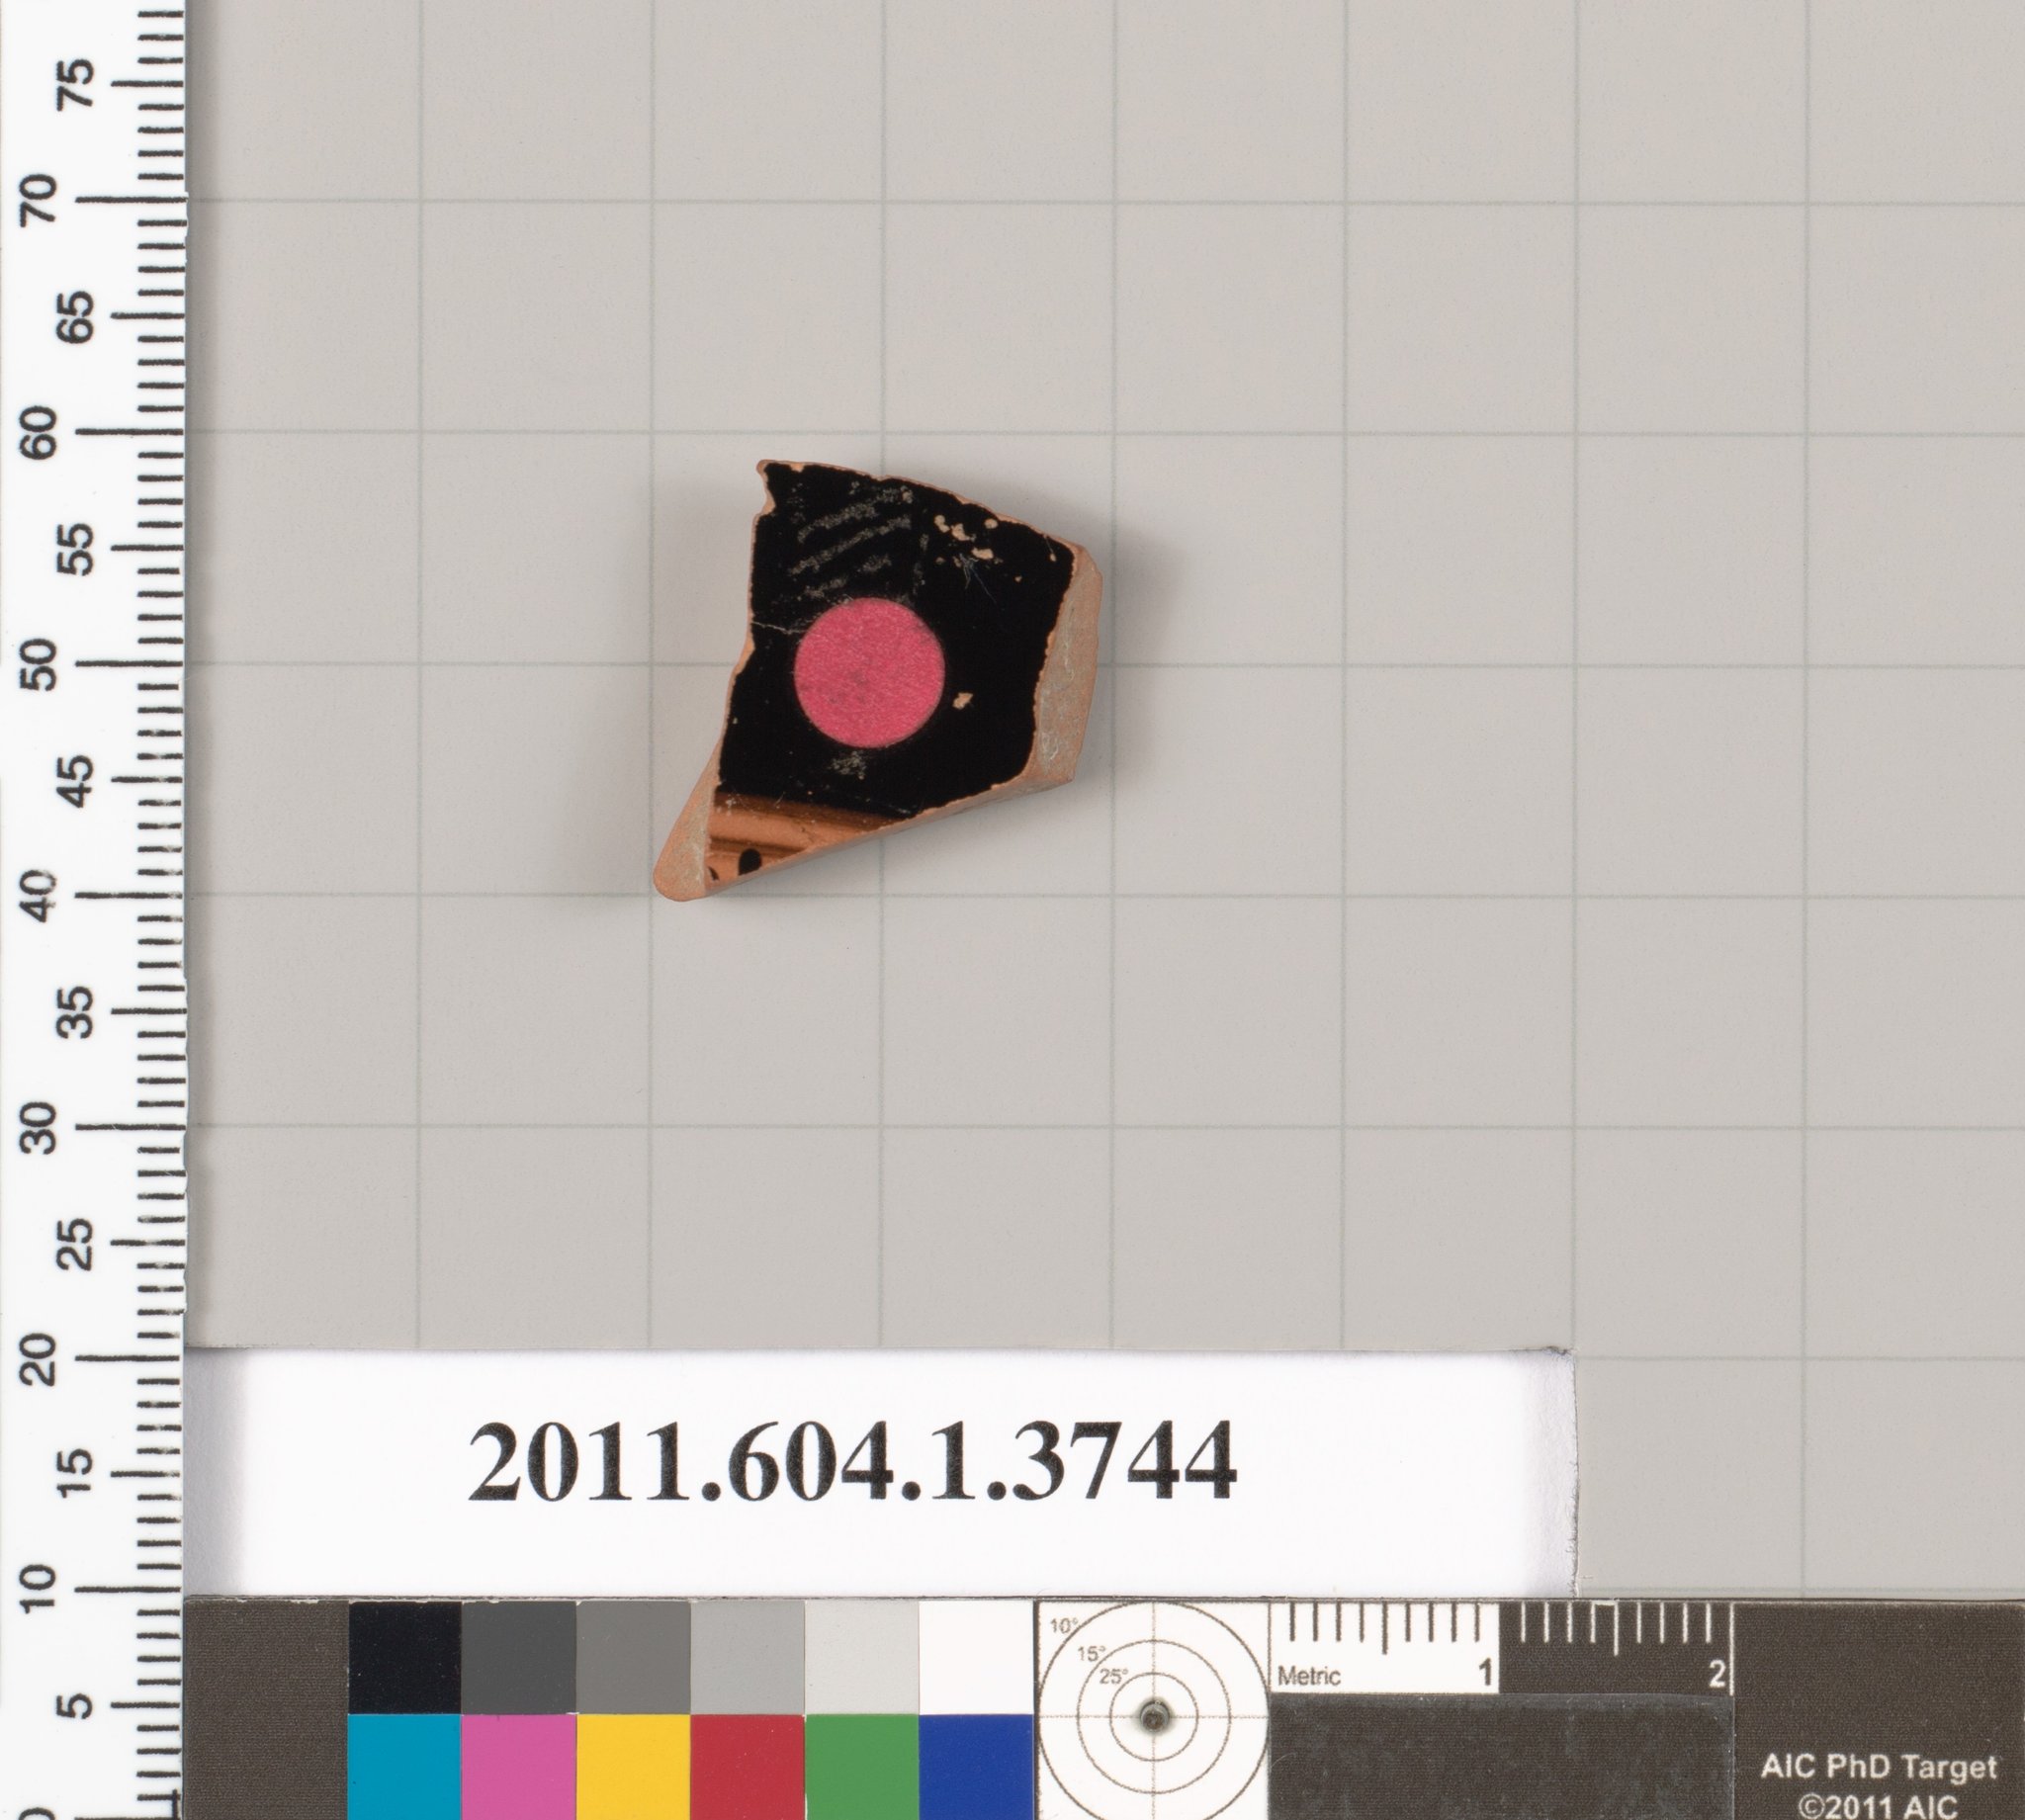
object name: kylix fragment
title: Terracotta fragment of a kylix (drinking cup)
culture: greek, attic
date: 490-470 BCE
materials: terracotta